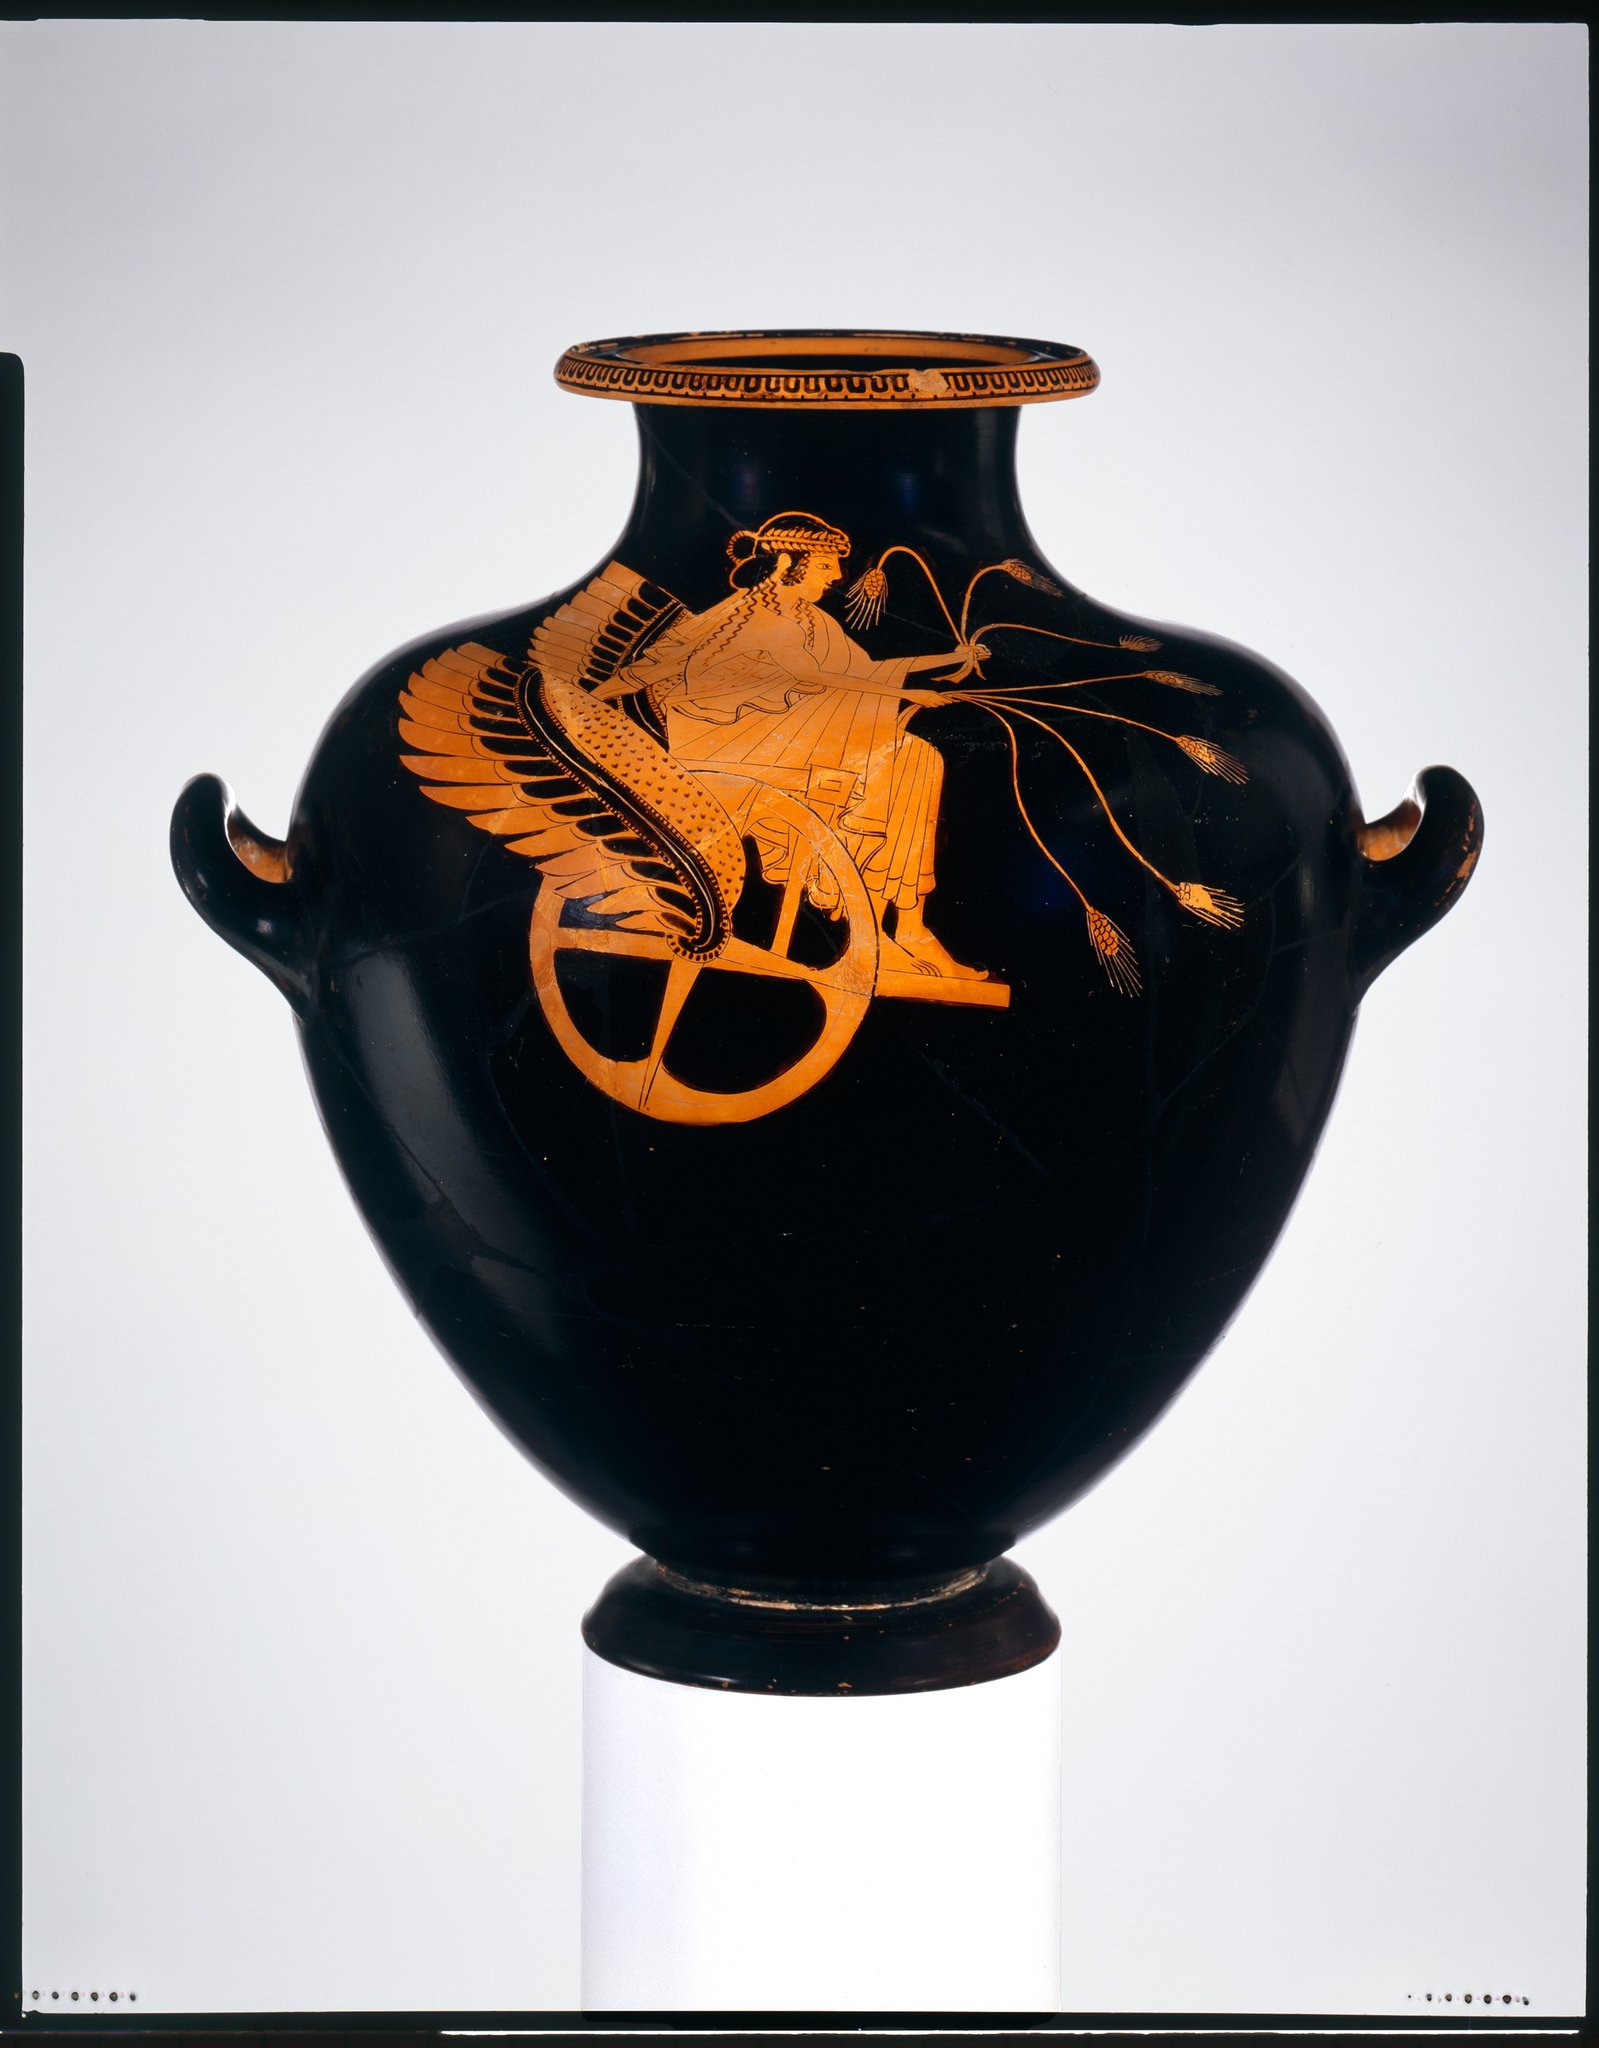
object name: hydria, kalpis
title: Terracotta hydria (water jar)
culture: greek, attic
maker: troilos painter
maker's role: artist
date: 490 BCE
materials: terracotta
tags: chariots,wheat